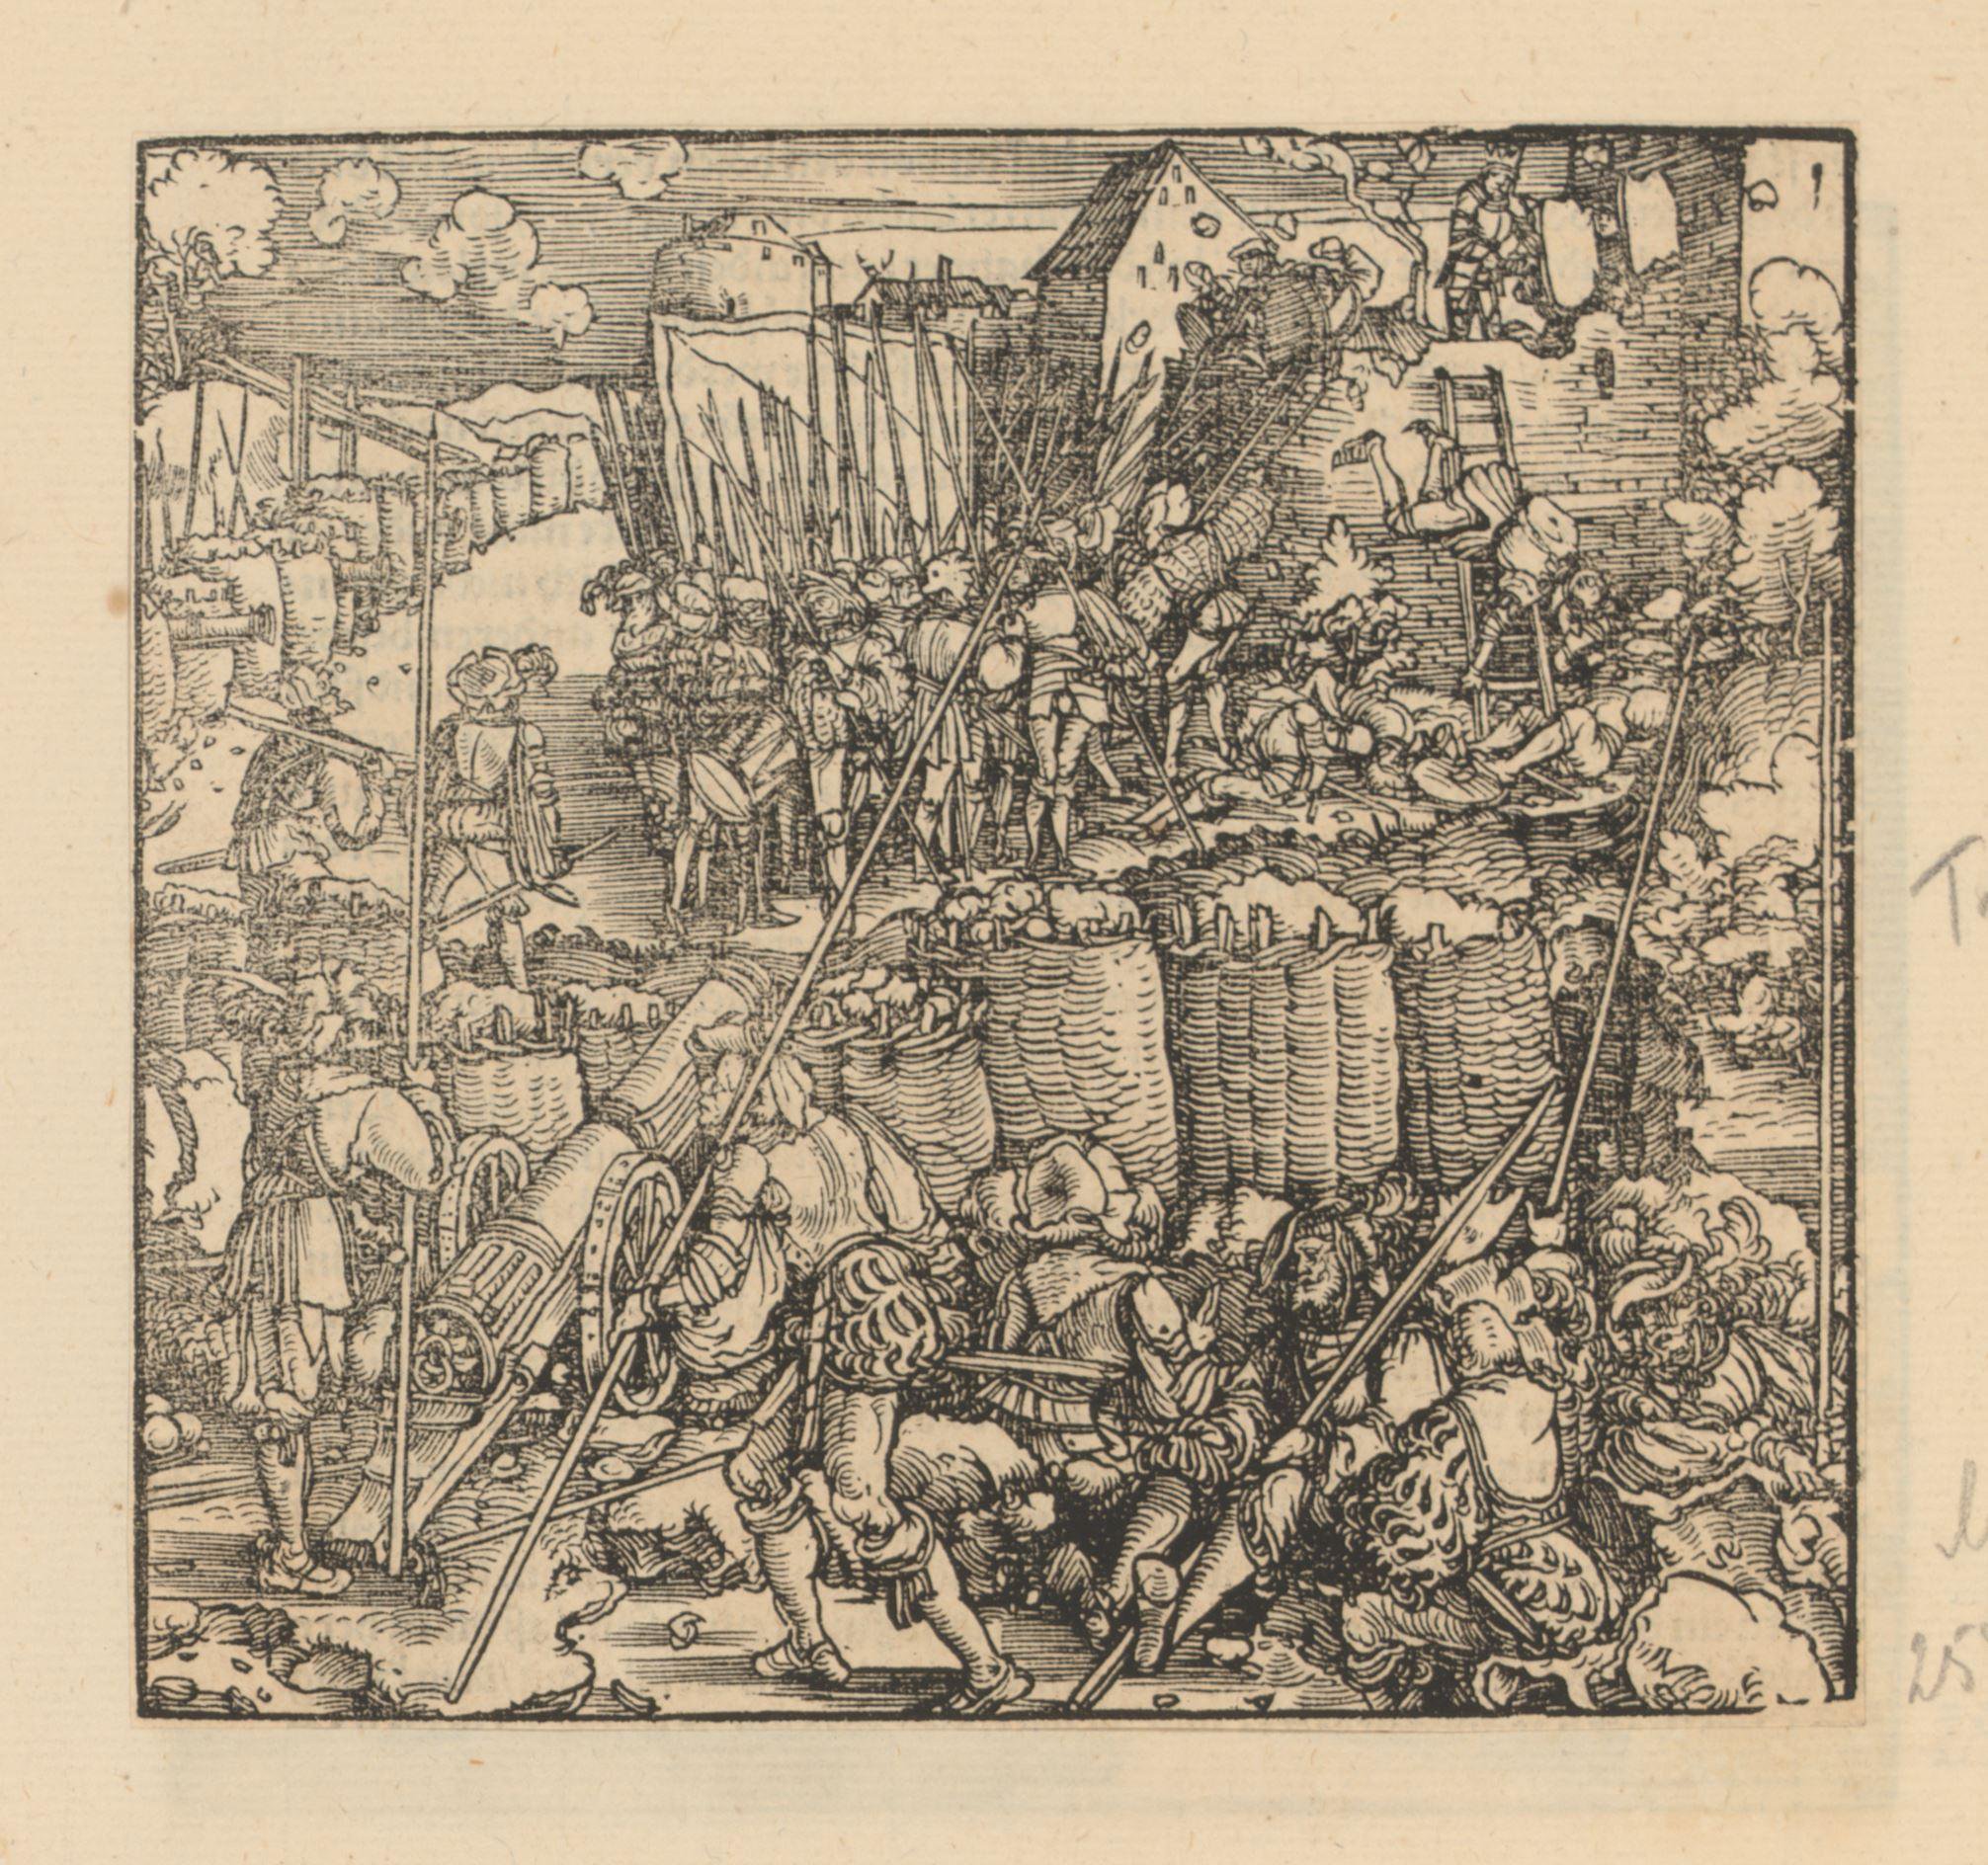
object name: album leaf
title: Belegering van een vestingstad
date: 1514-1532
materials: paper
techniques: letterpress printing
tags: attack ~ siege, firearms: cannon, fortified city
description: Deze prent is gebruikt in: Petrarca, Francesco. Von der Artzney bayder Glück, des guten und widerwertigen: unnd weß sich ain yeder inn Gelück und Unglück halten sol (...). Augsburg: Heinrich Steiner, 1532. Deze uitgave is ook bekend onder de titel 'Trostspiegel in Glück und Unglück'. Deze prent is ook gebruikt in: Cicero, Marcus Tulius. Officia M.T.C. Ein Buch so Marcus Tullius Cicero der Römer zu seynem (...). [Vertaald uit het Latijn door] Johann von Schwarzenberg. Augsburg: Heinrich Steiner, 1531.